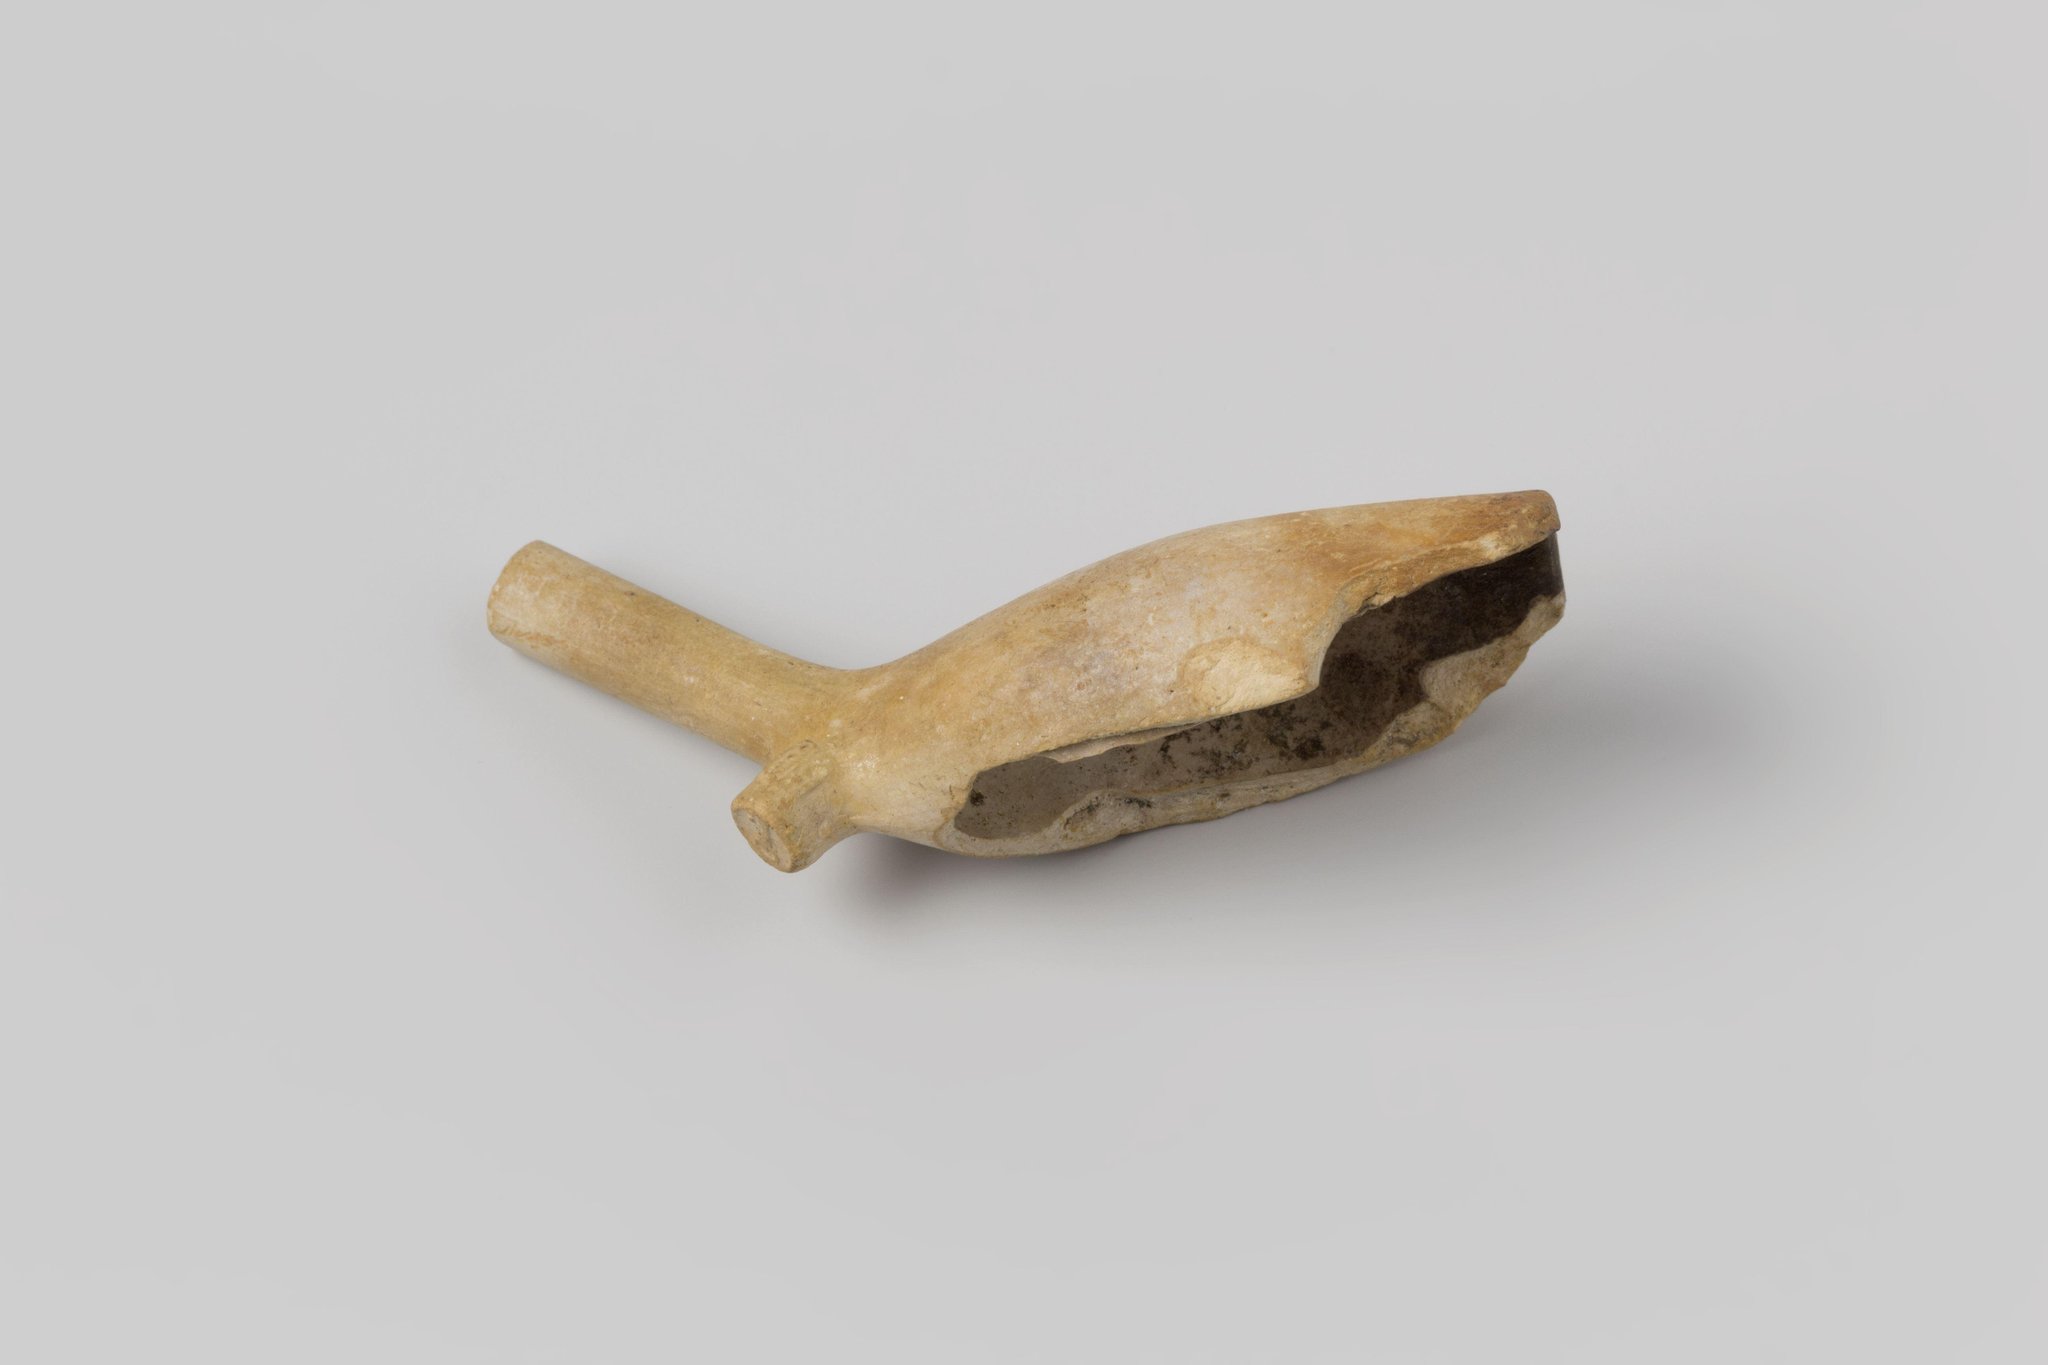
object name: pipe bowl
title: Fragment pijpenkop met stuk steel uit het wrak van de Oost-Indiëvaarder Hollandia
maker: Anonymous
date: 1700-1743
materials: clay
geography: netherlands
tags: verenigde oostindische compagnie, hollandia (schip), annet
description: Pipe, bowl, heelmark: key; fragm, 2hsm3, inside burned (used).